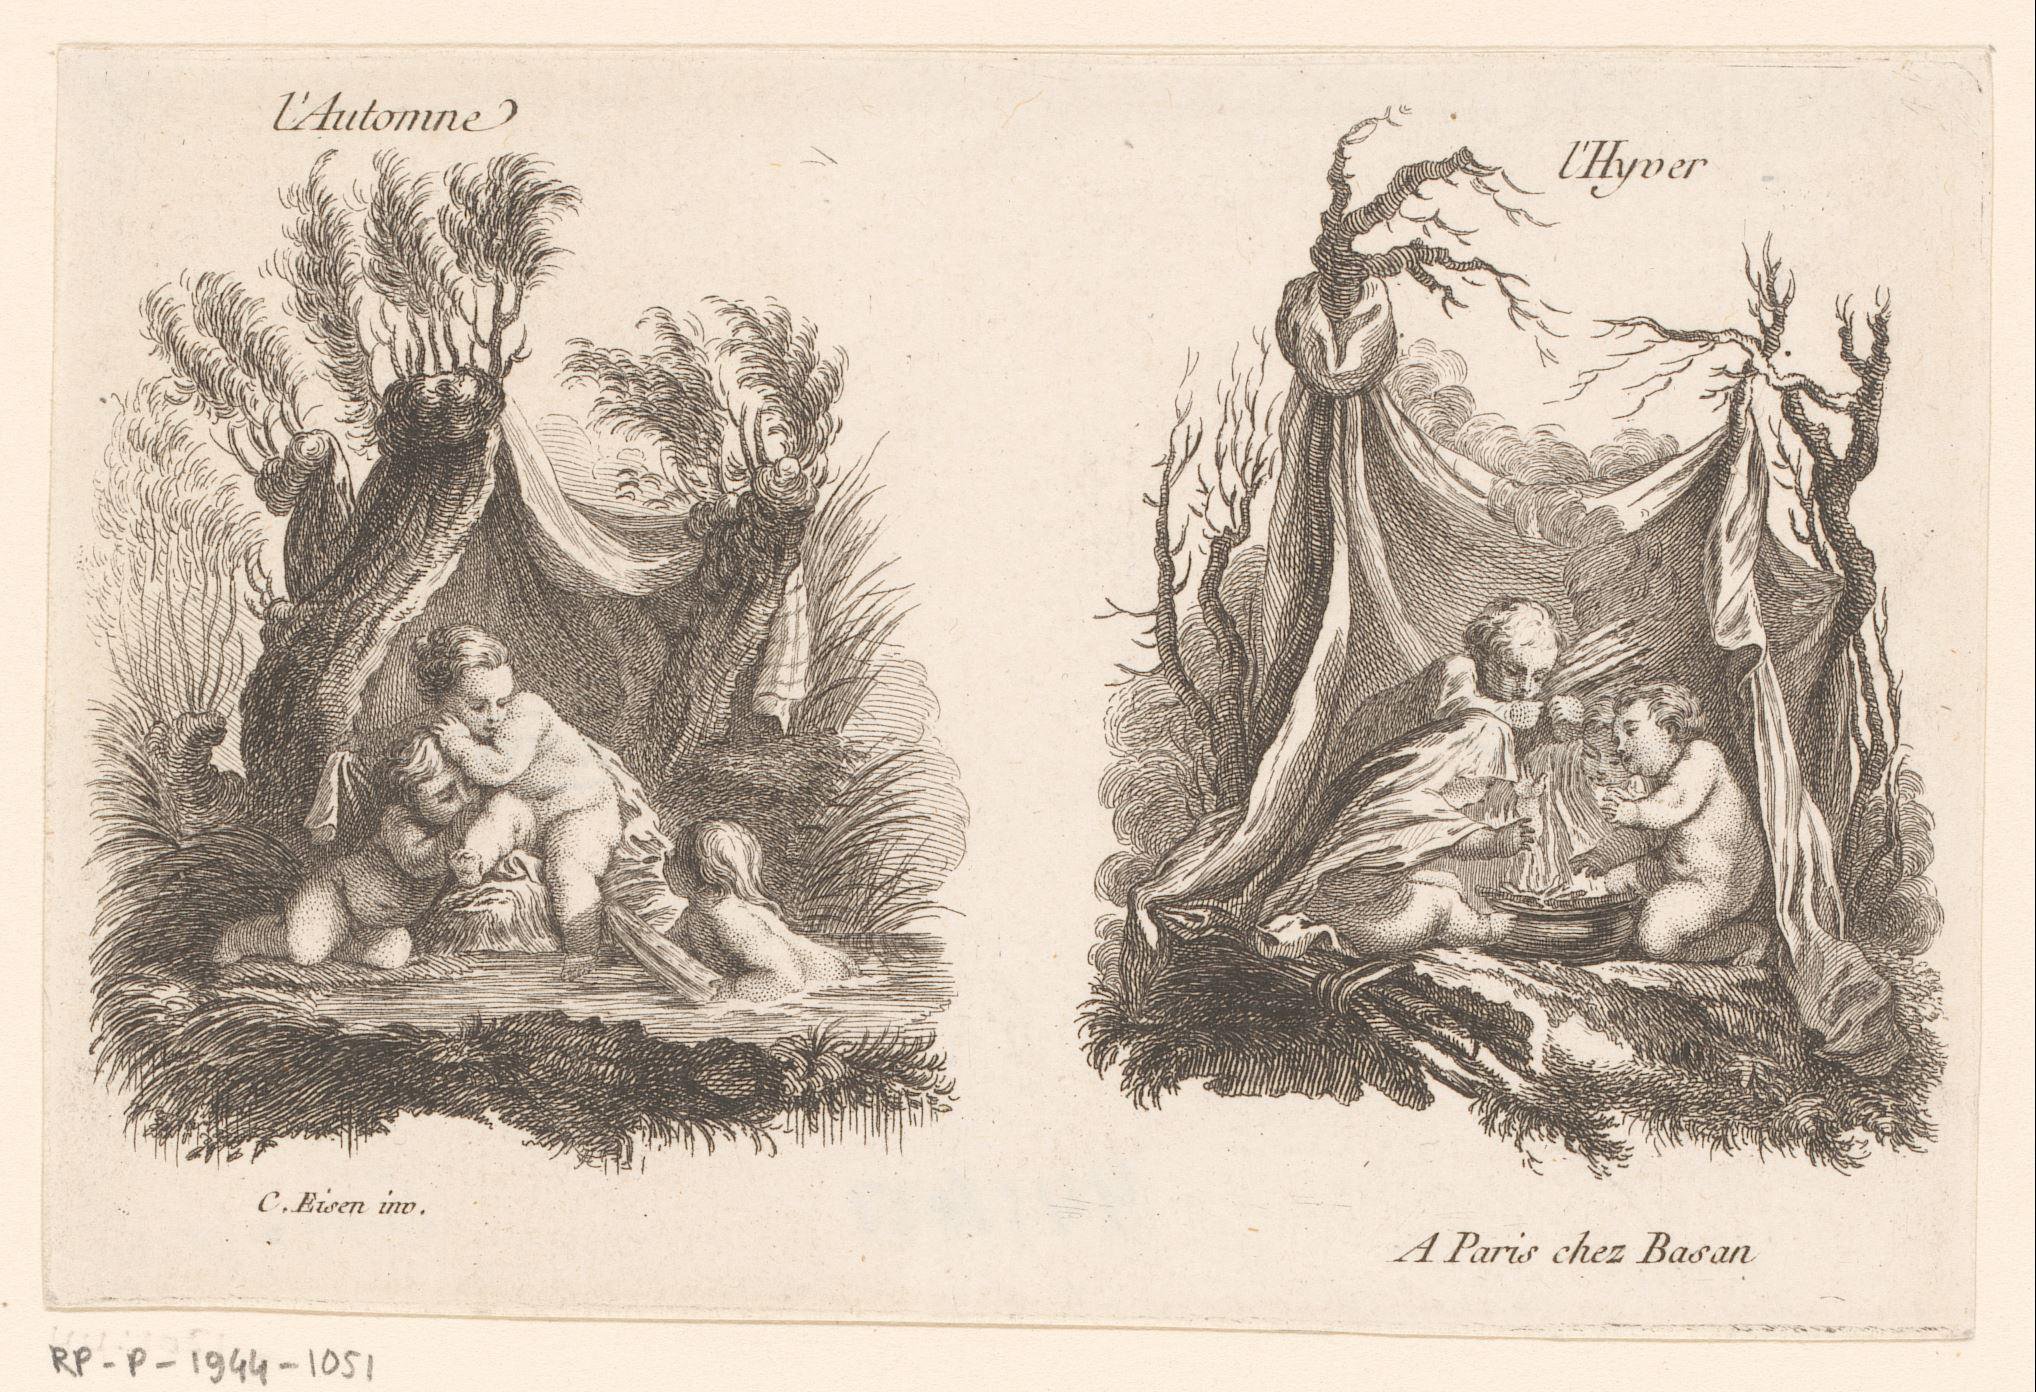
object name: print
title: Personificatie van de herfst en de winter met amors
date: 1733-1797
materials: paper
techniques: etching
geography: paris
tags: winter, 'hyems'; 'inverno' (ripa), cupids: 'amores', 'amoretti', 'putti', autumn, fall, 'autumnus'; 'autunno' (ripa)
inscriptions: collector's mark: Lugt 2228